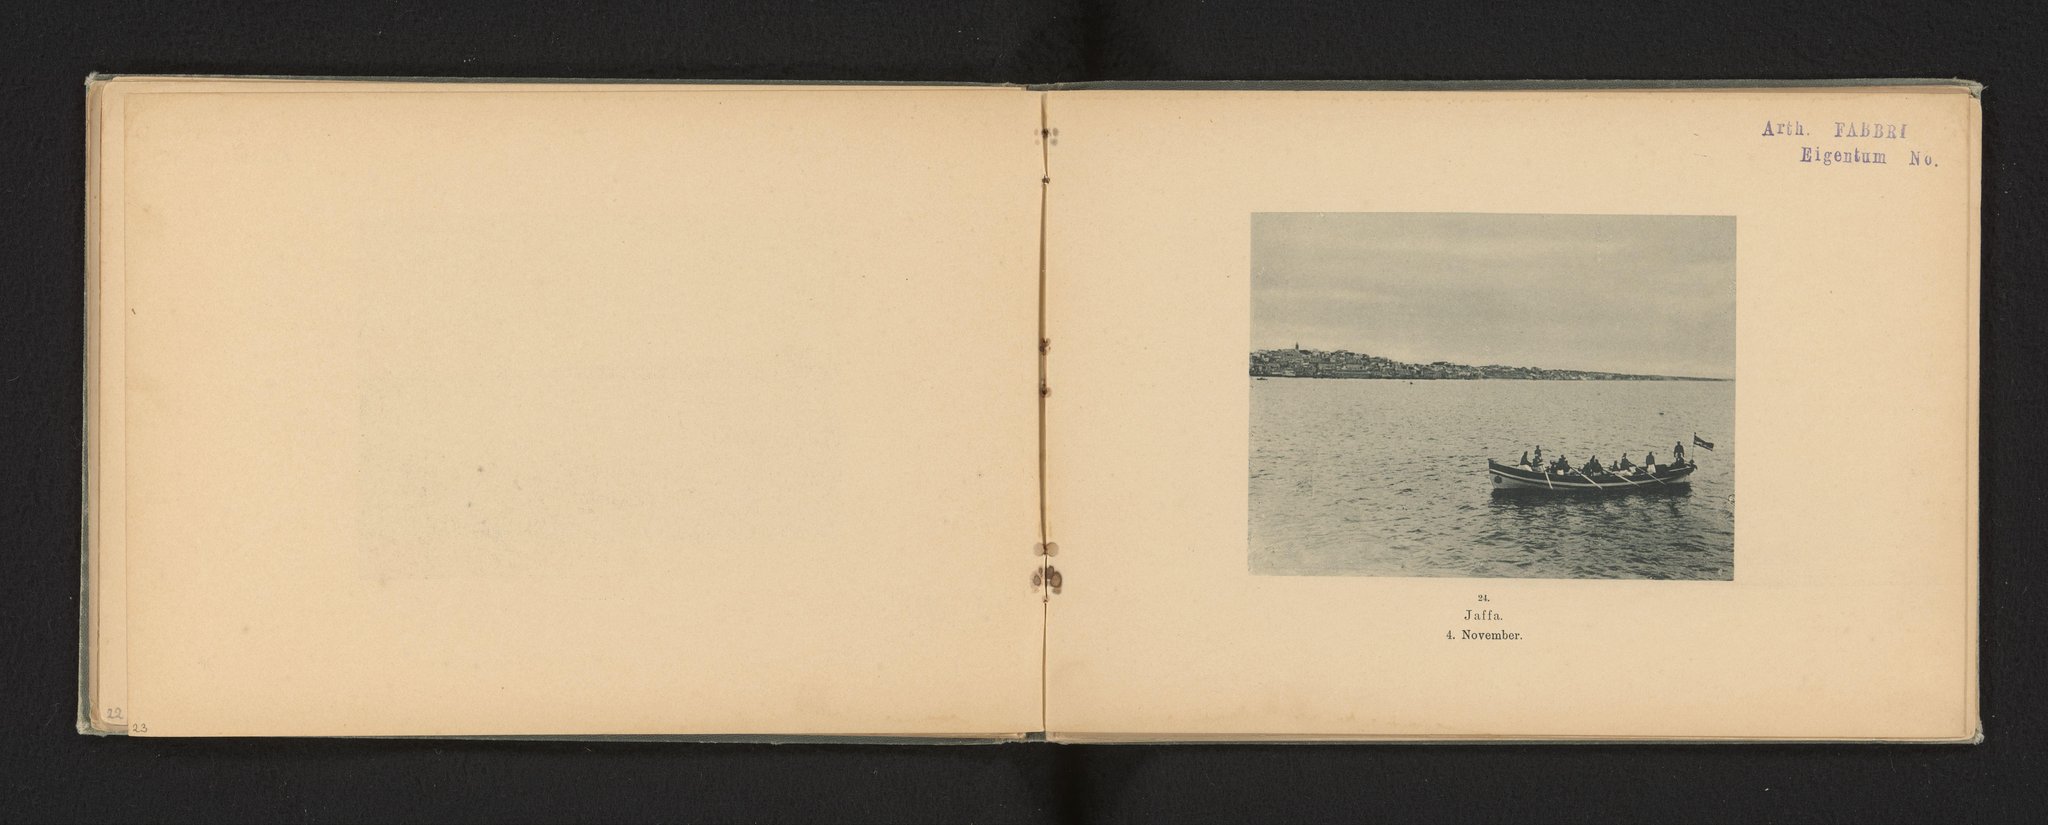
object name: photomechanical print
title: Jaffa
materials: paper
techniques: photograph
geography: jaffa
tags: canals, waters (in city), prospect of city, town panorama, silhouette of city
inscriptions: number: ‘24.’, collector's mark: ‘Arth. FABBRI/ Eigentum No.’